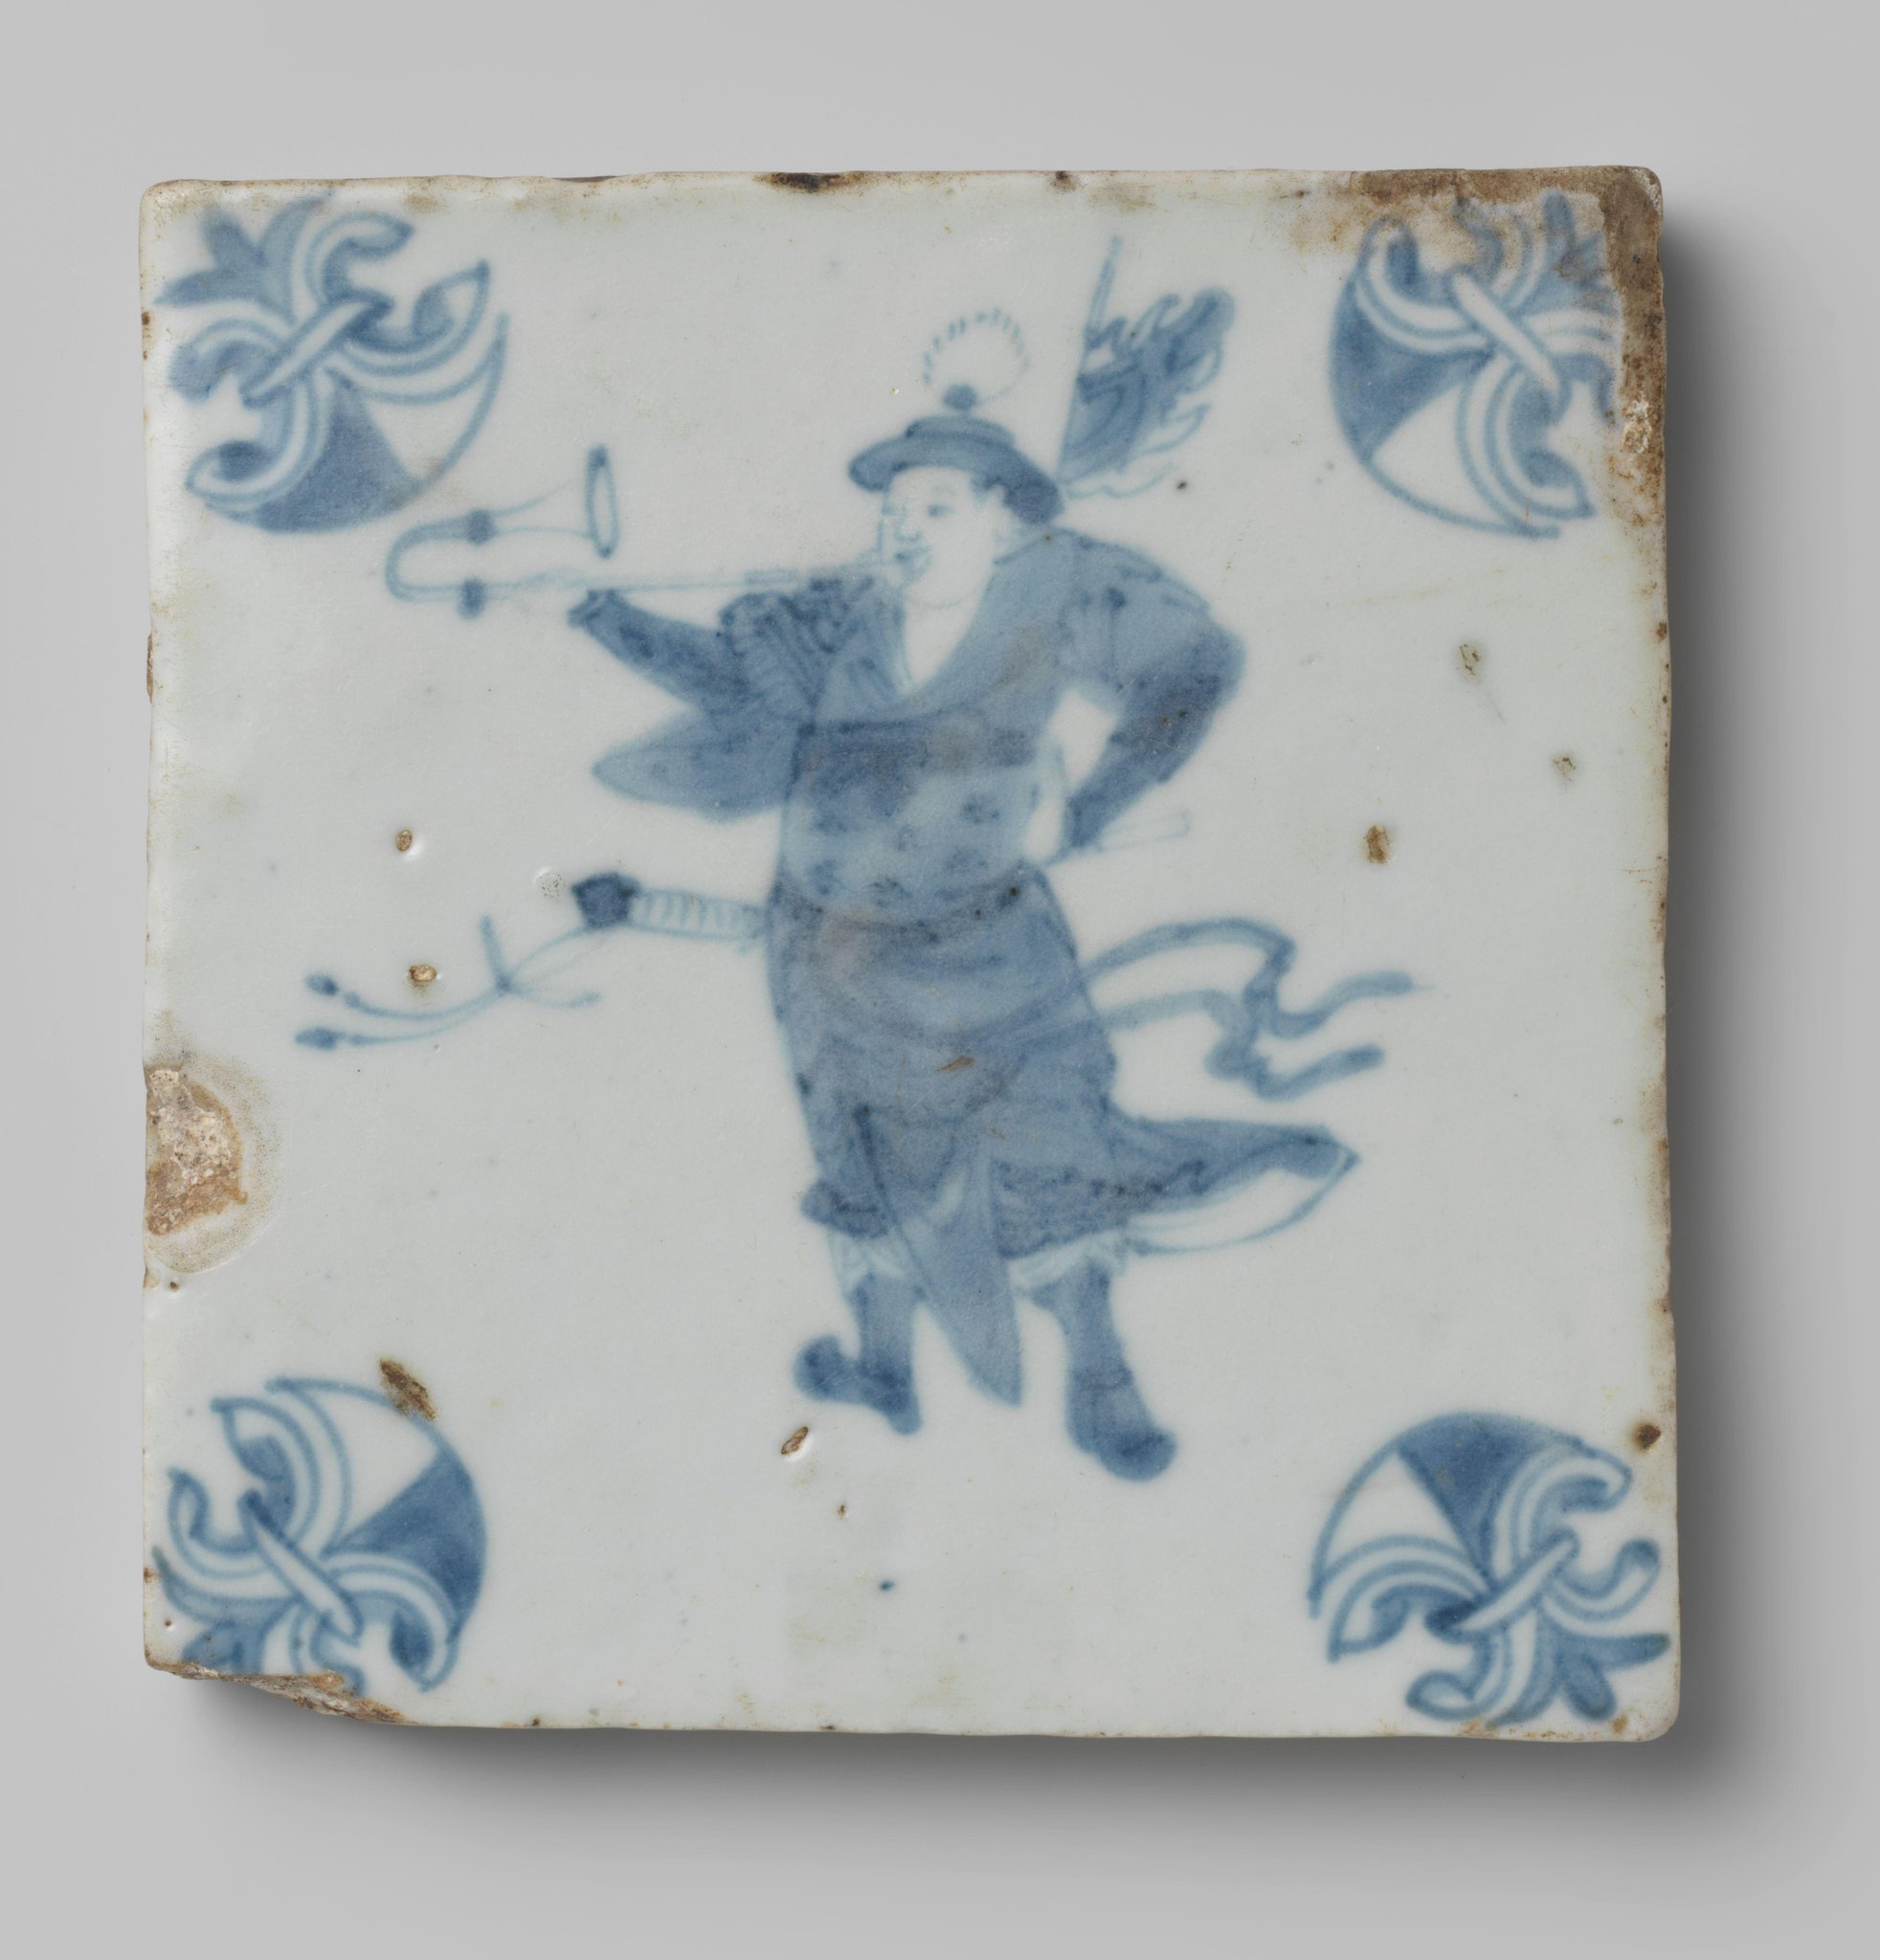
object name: tile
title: Tile with a man holding a trumpet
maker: Anonymous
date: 1635-1645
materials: cobalt, glaze, paint, porcelain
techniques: firing, forming, vitrification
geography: china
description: Tegel van porselein, beschilderd in onderglazuur blauw. In het centrum een man met een blaasinstrument aan zijn mond. In elke hoek een Europees fleur-de-lis motief. Tegel is beschadigd. Overgangsporselein in blauw-wit.